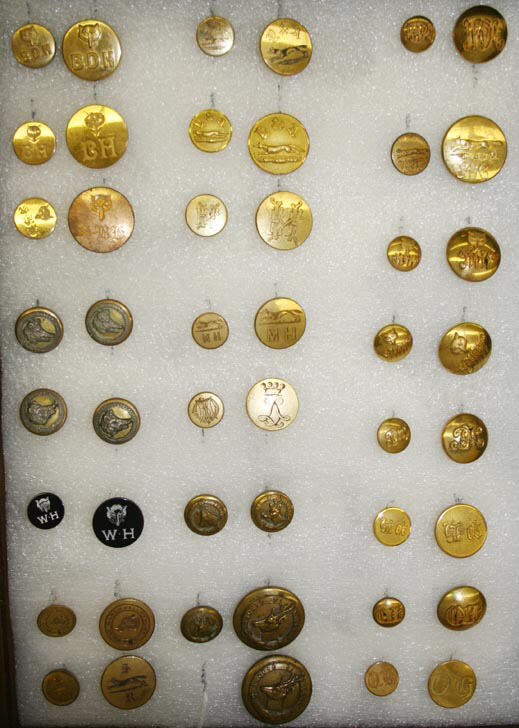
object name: button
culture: british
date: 1850-1880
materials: metal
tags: deer,foxes